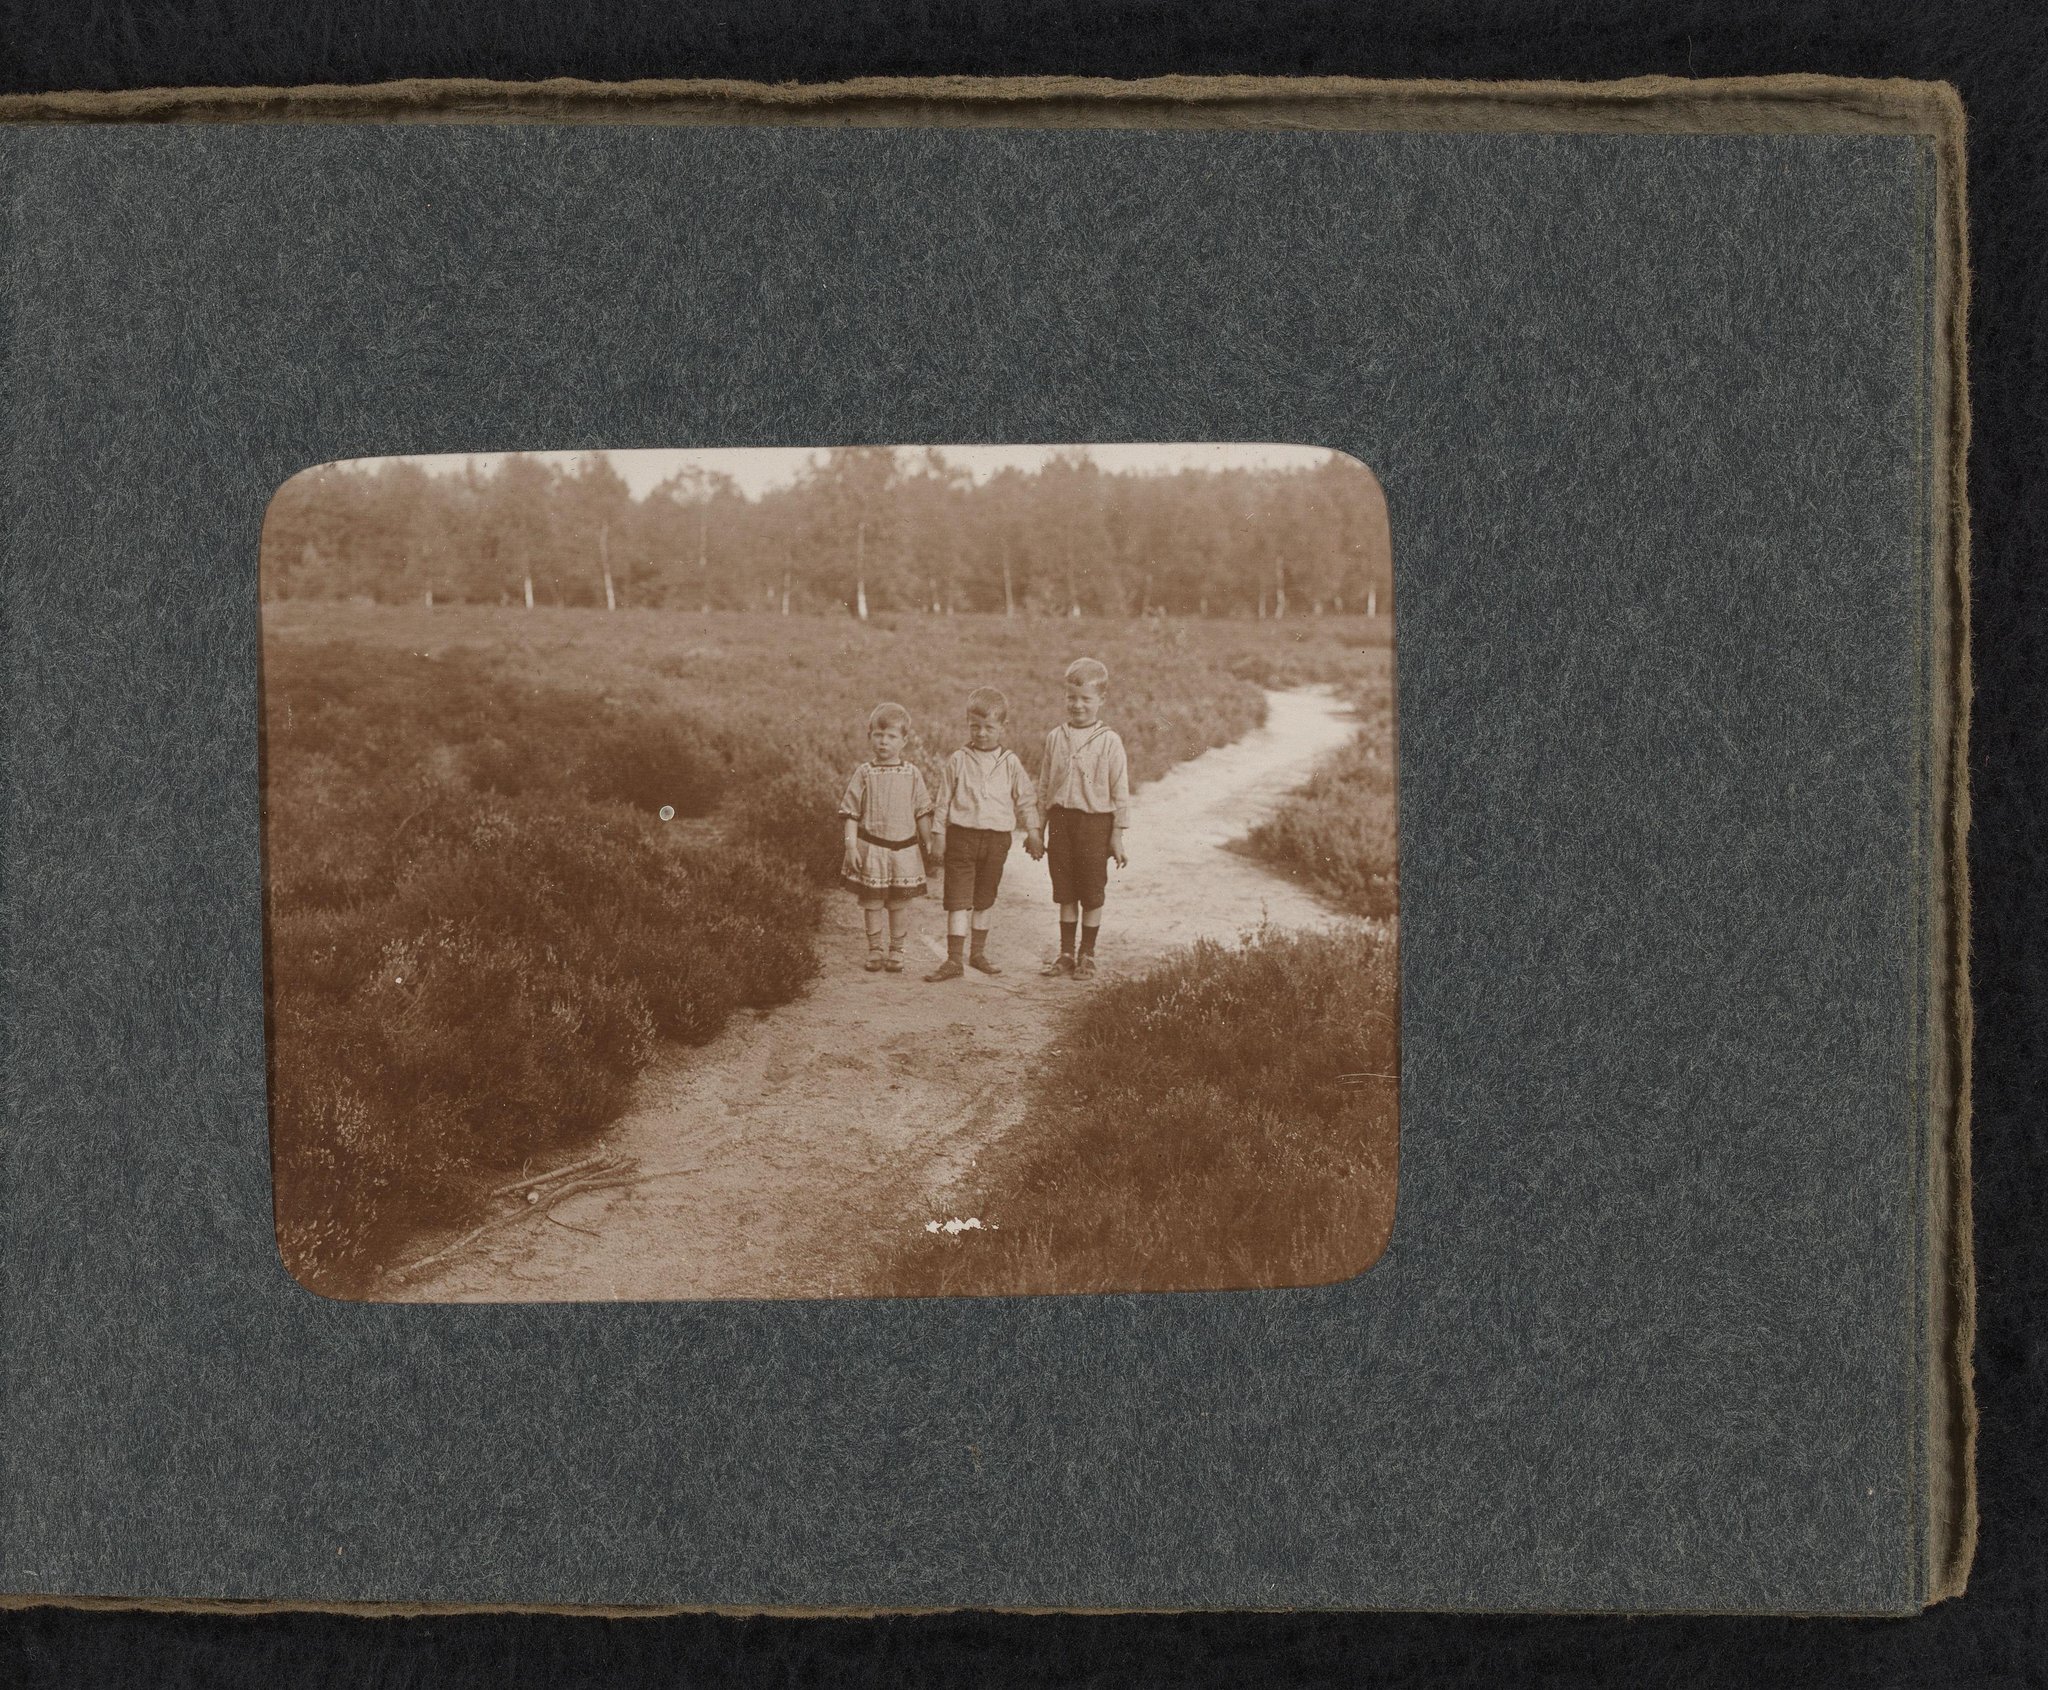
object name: photograph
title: Drie kinderen van de familie van den Berg op de heide in Huis ter Heide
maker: hendrik herman van den berg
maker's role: amateurfotograaf, jurist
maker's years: 1875-1944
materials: paper, cardboard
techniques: gelatin silver print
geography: huis ter heide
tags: family life